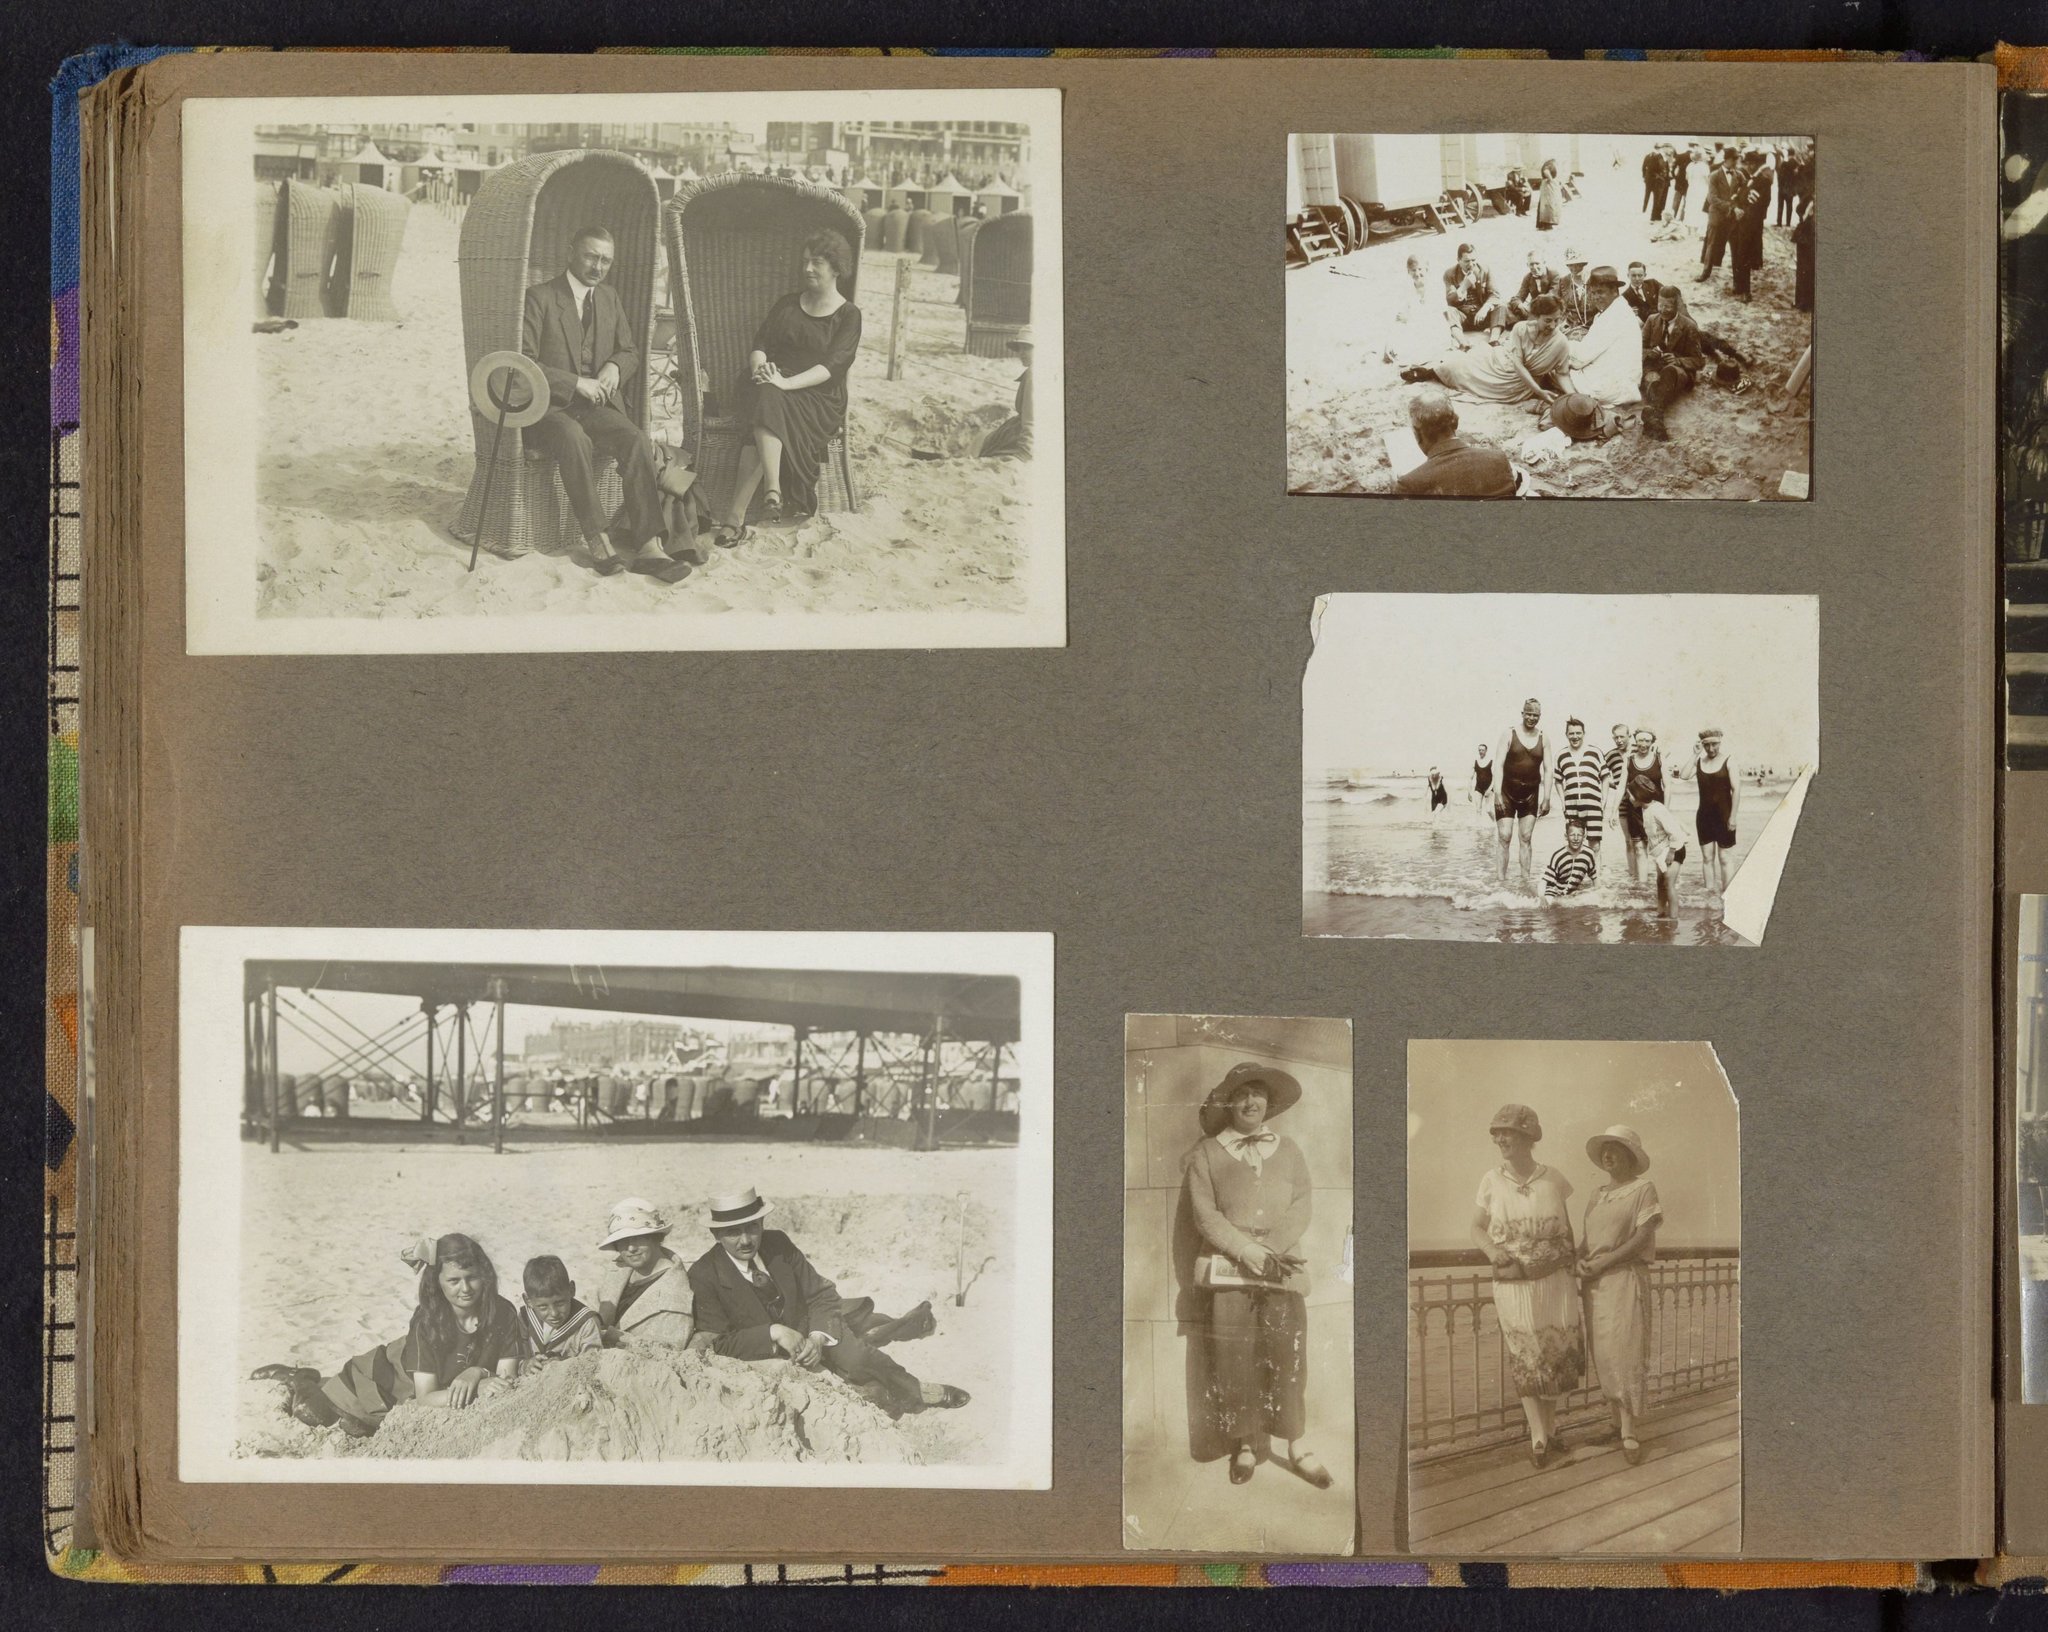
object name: album leaf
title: Strandtaferelen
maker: Anonymous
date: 1900-1925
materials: cardboard, photographic support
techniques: gelatin silver print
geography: scheveningen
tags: beach (as place of recreation), adult woman, adult man, pier, quay, wharf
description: Albumblad met foto's van mensen aan het strand, vermoedelijk in Scheveningen, en op de pier aldaar. Onderdeel van Fotoalbum van een onbekende Nederlandse familie met connecties in Suriname en Nederlands-Indië (1).